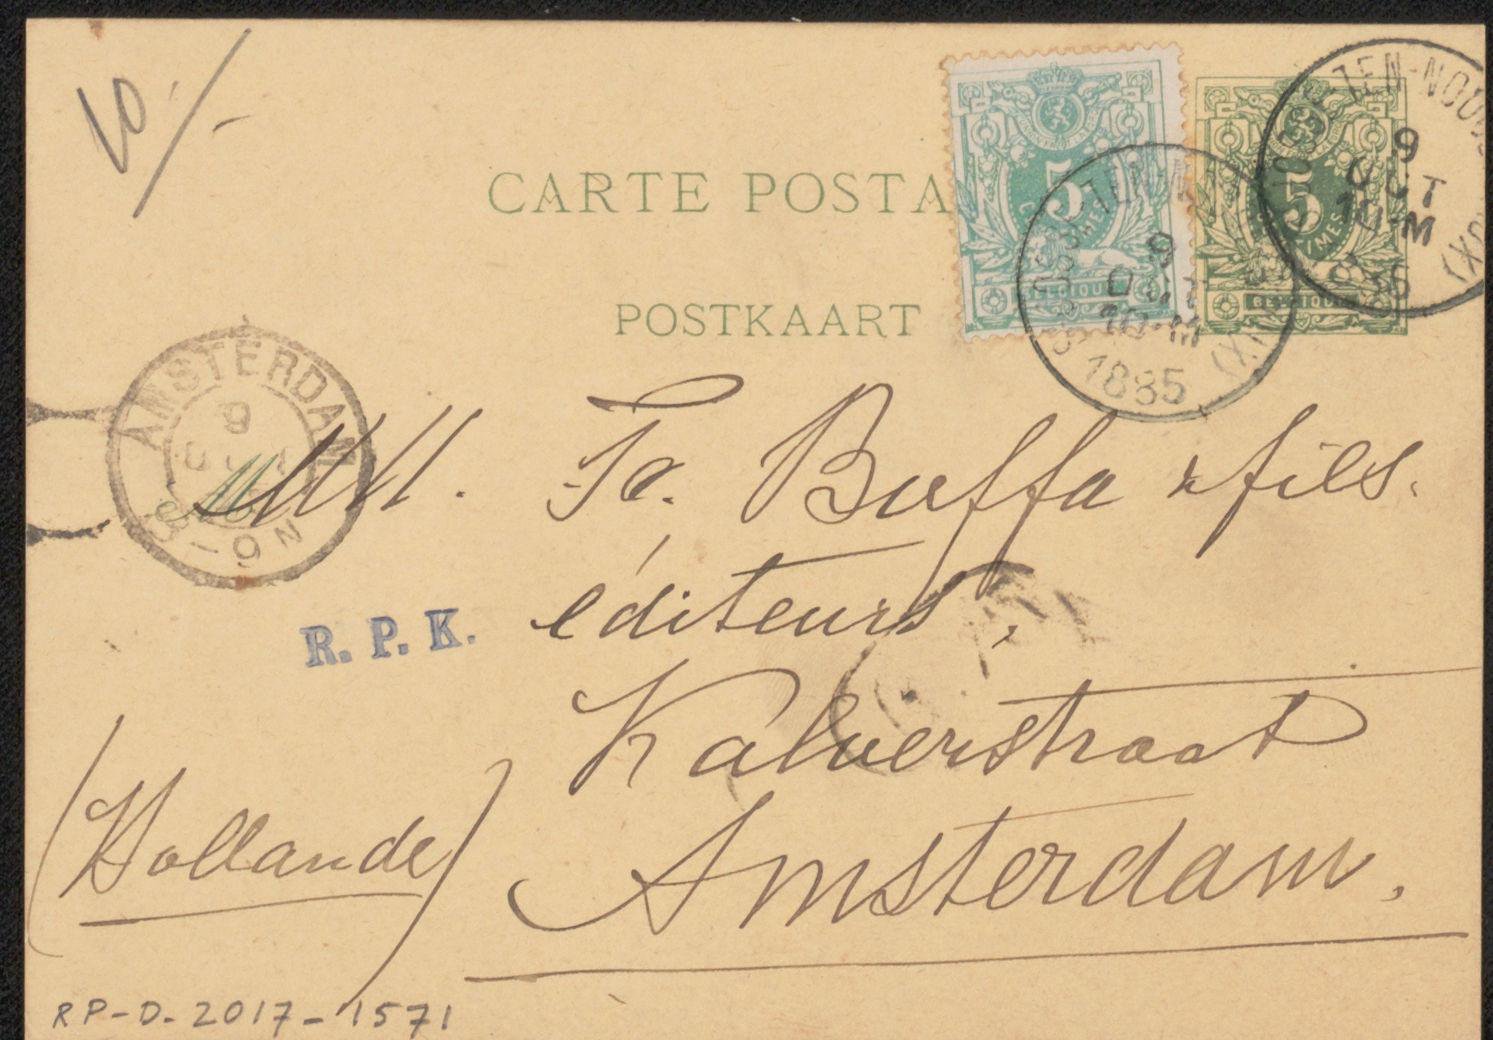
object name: postcard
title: Briefkaart aan Frans Buffa en Zonen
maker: willem roelofs (i)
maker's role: draughtsman, painter, print maker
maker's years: 1822-1897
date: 1885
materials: cardboard, ink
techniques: pen, writing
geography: brussels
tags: publisher, art trade, art shop, money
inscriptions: collector's mark: Lugt 2233